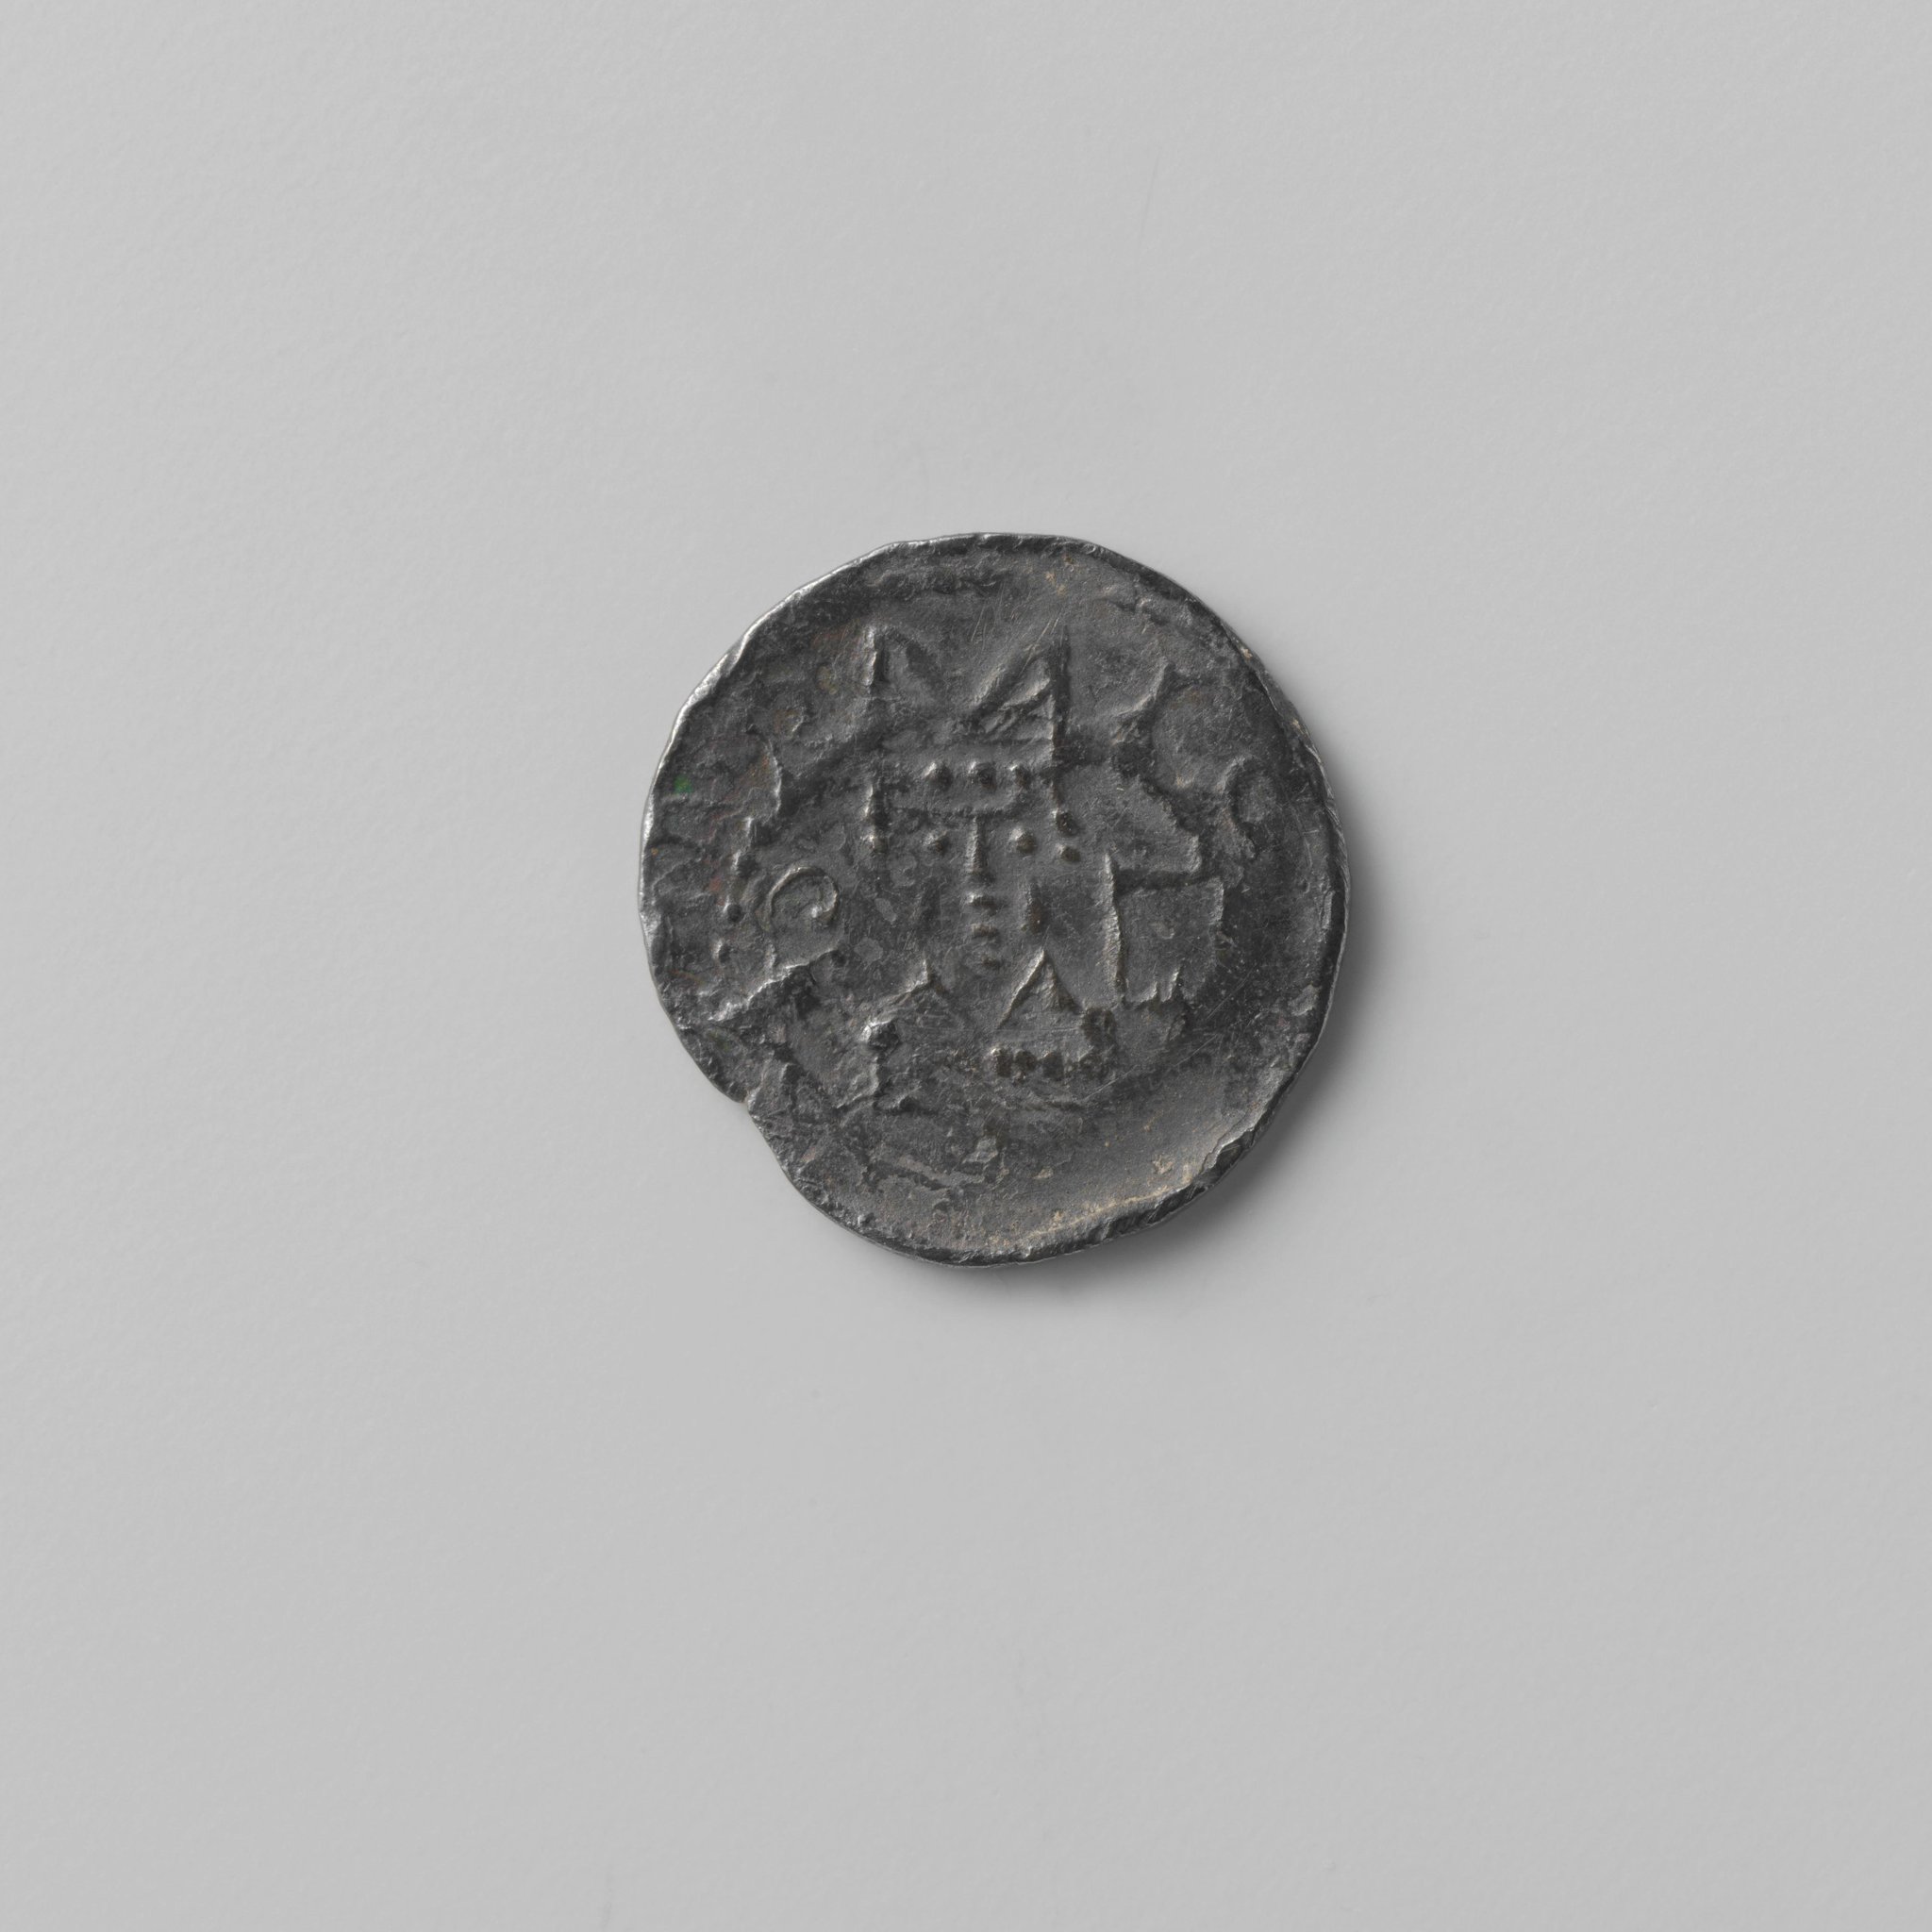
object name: coin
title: Utrecht, Hendrik van Vianden, penning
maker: hendrik i van vianden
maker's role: bisschop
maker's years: -1267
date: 1250-1267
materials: silver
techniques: striking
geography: deventer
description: Zilveren munt. Voorzijde: portret van de bisschop van voren met mijter met in rechterhand bisschopsstaf, in linkerhand boek. Keerzijde: lang dubbellijnig kruis, in hoeken P,A,X en sterretje.